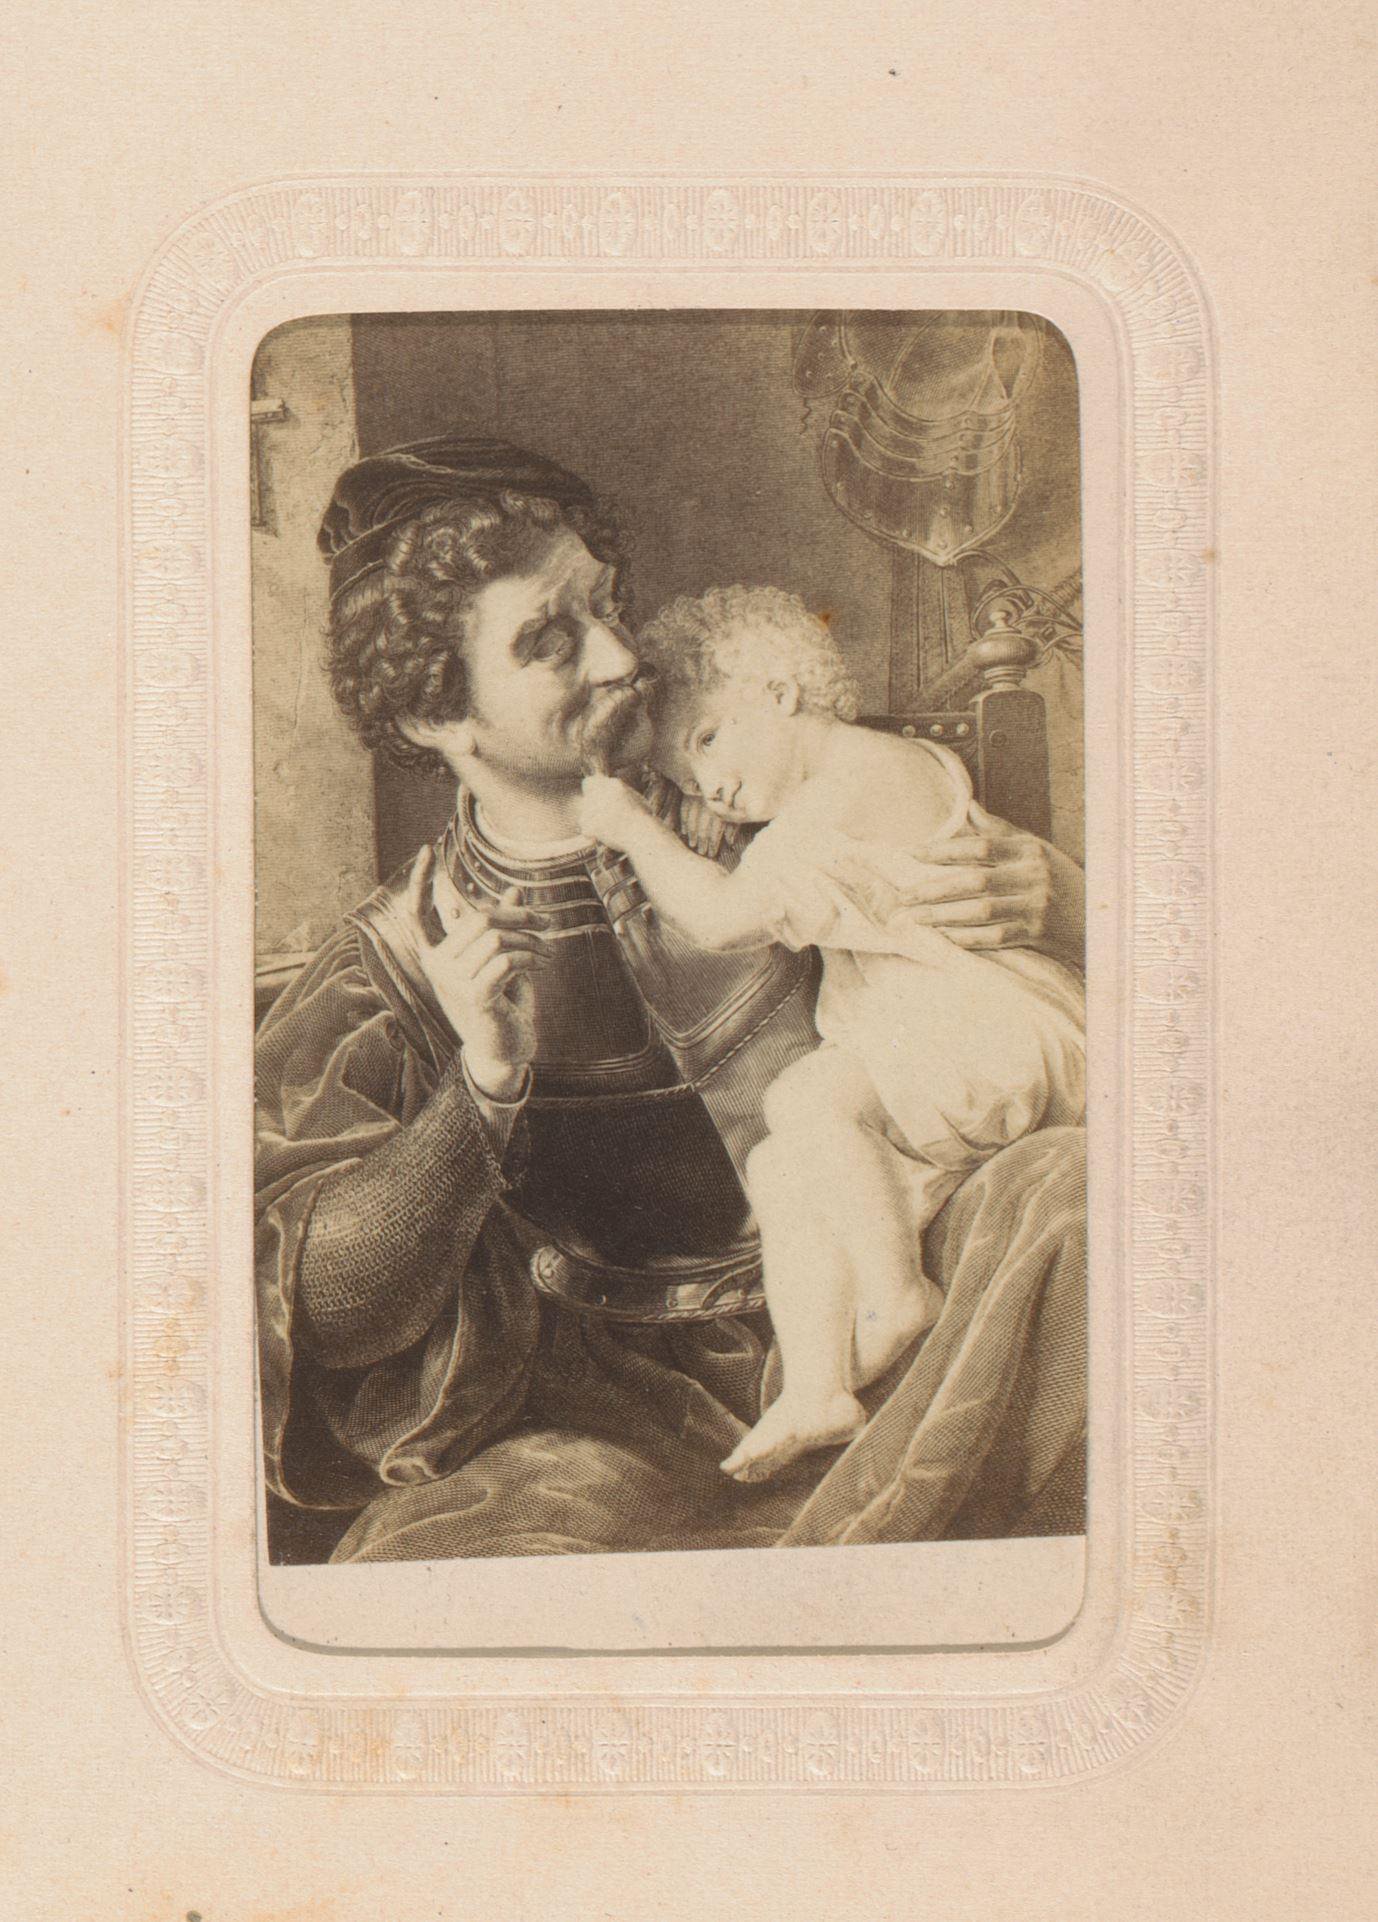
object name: album leaf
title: Fotoreproductie van een schilderij met vader en dochter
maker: Anonymous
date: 1855-1865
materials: cardboard, photographic support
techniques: albumen print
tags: father and daughter(s) (family group)